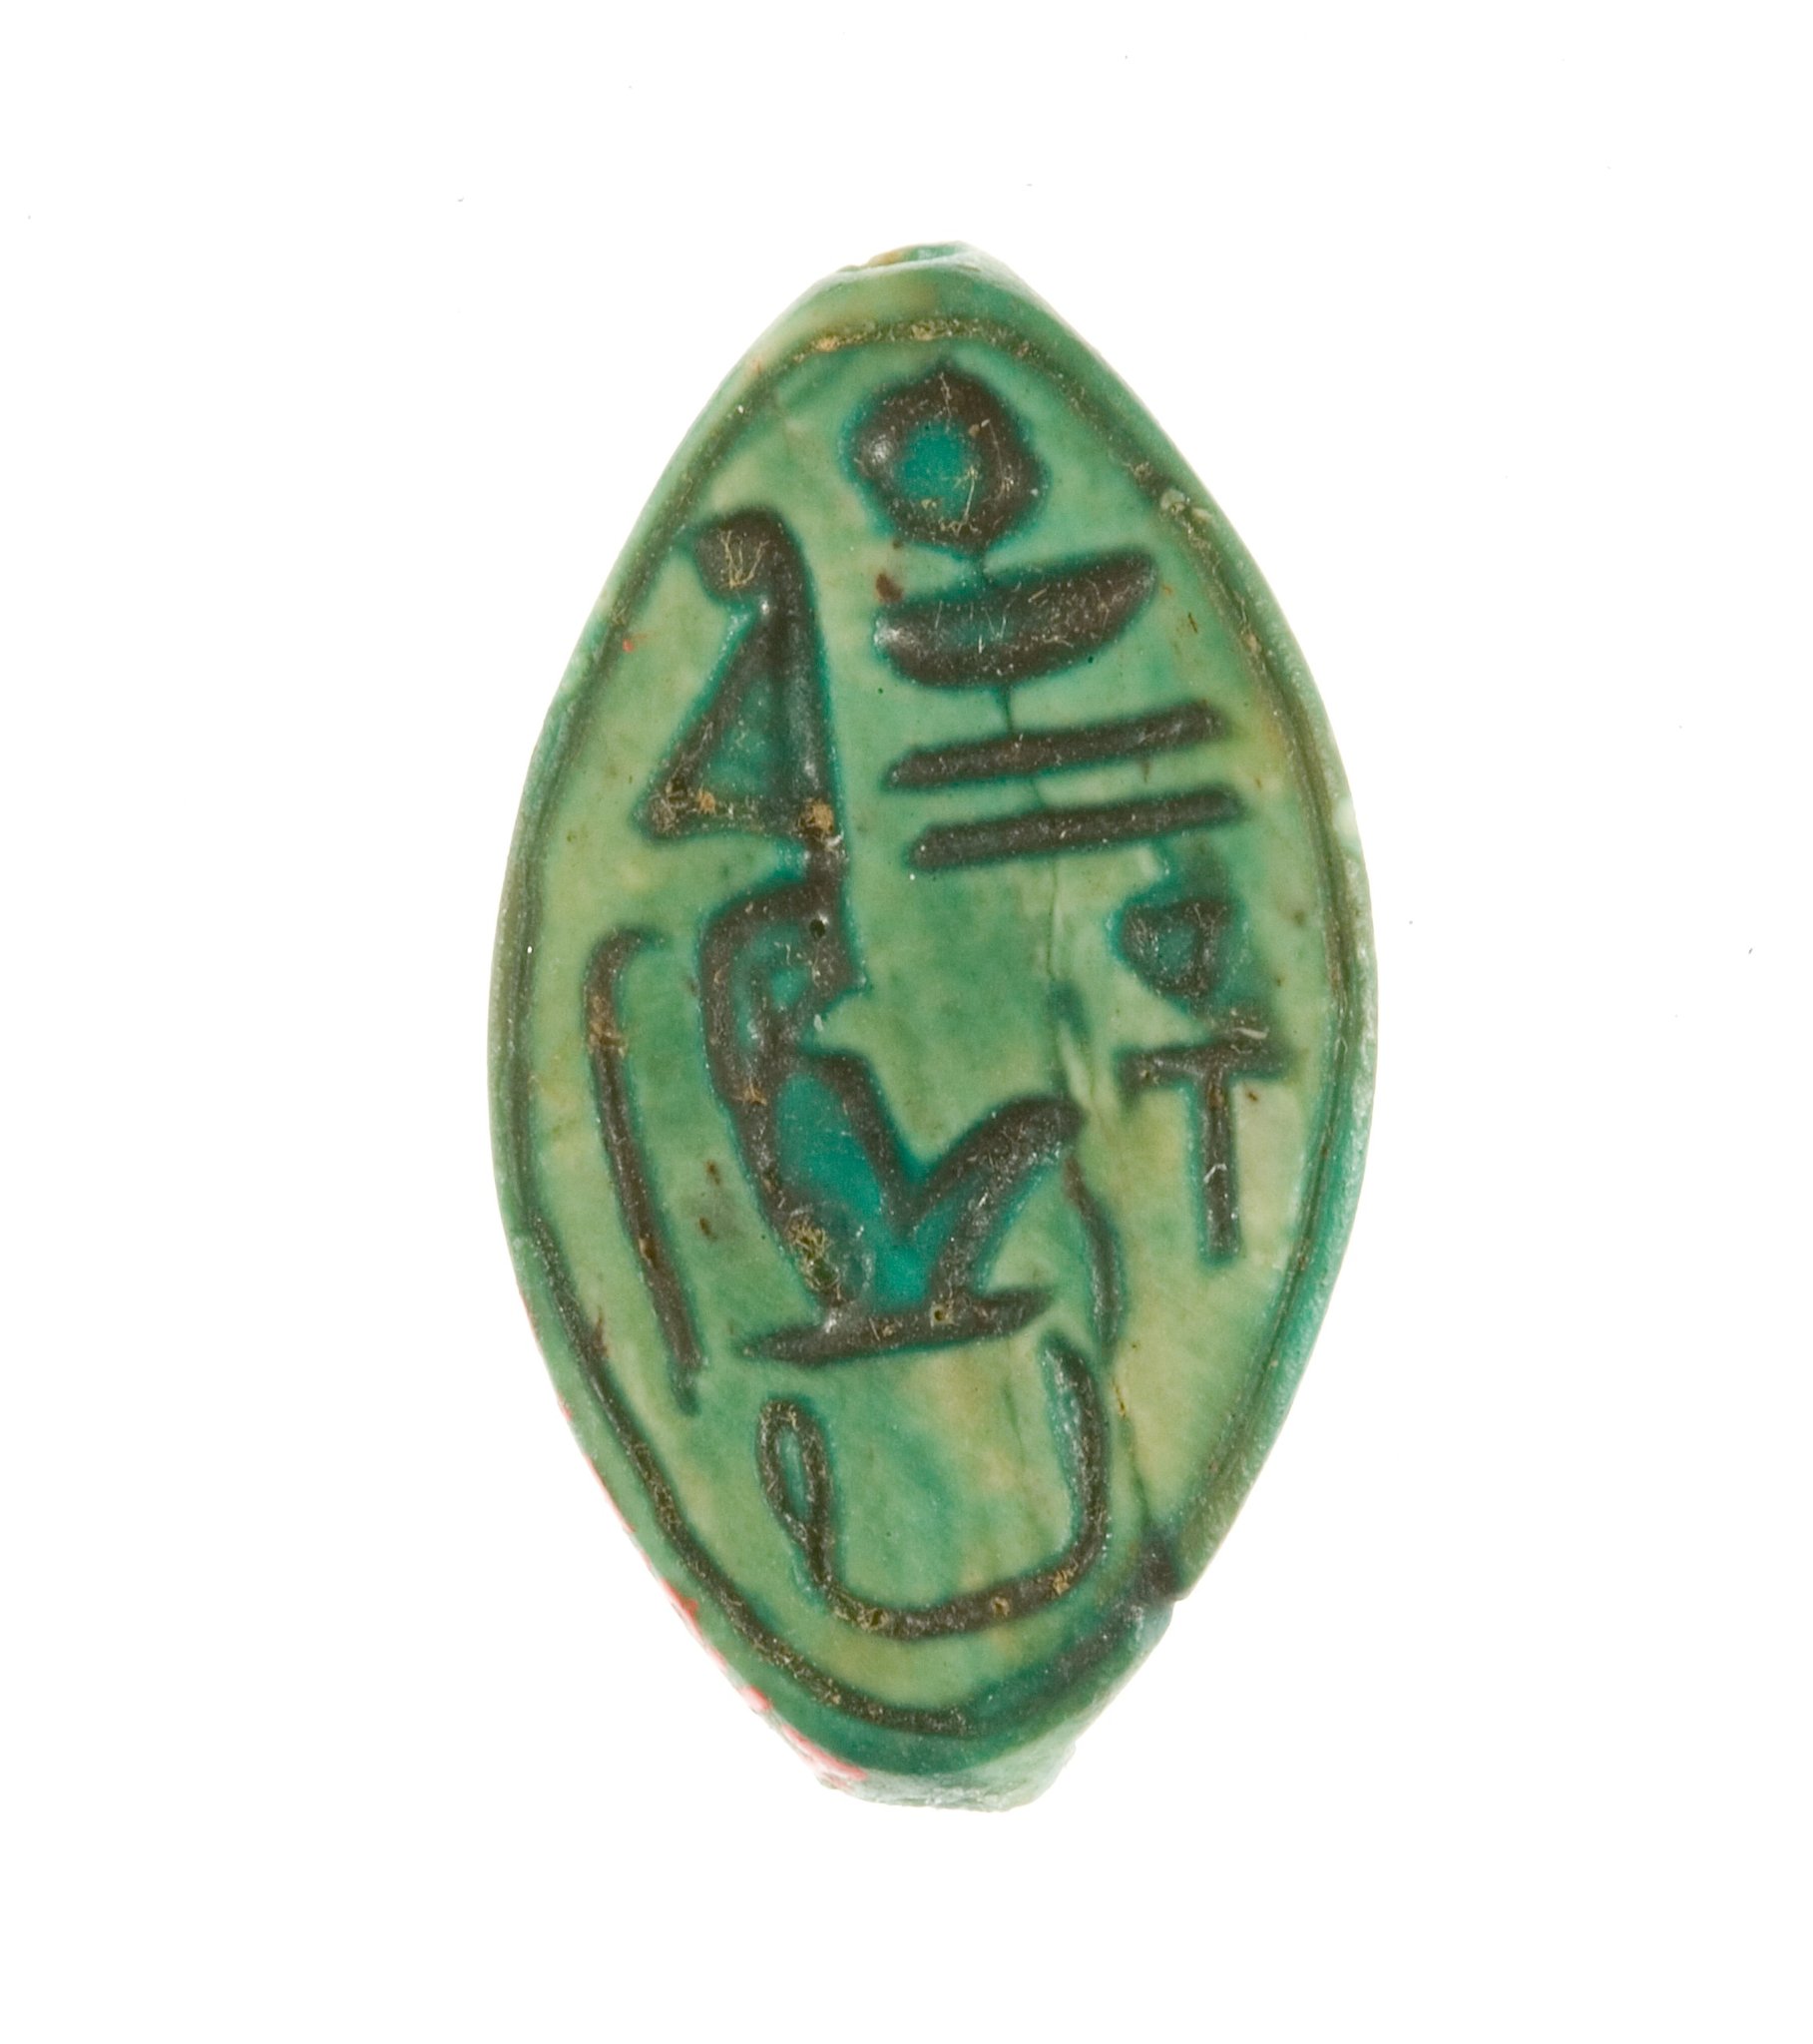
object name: cowroid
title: Cowroid Inscribed Lord of the Two Lands Maatkare (Hatshepsut), Living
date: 1479-1458 BCE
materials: stone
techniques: glazing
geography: egypt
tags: animals,hieroglyphs